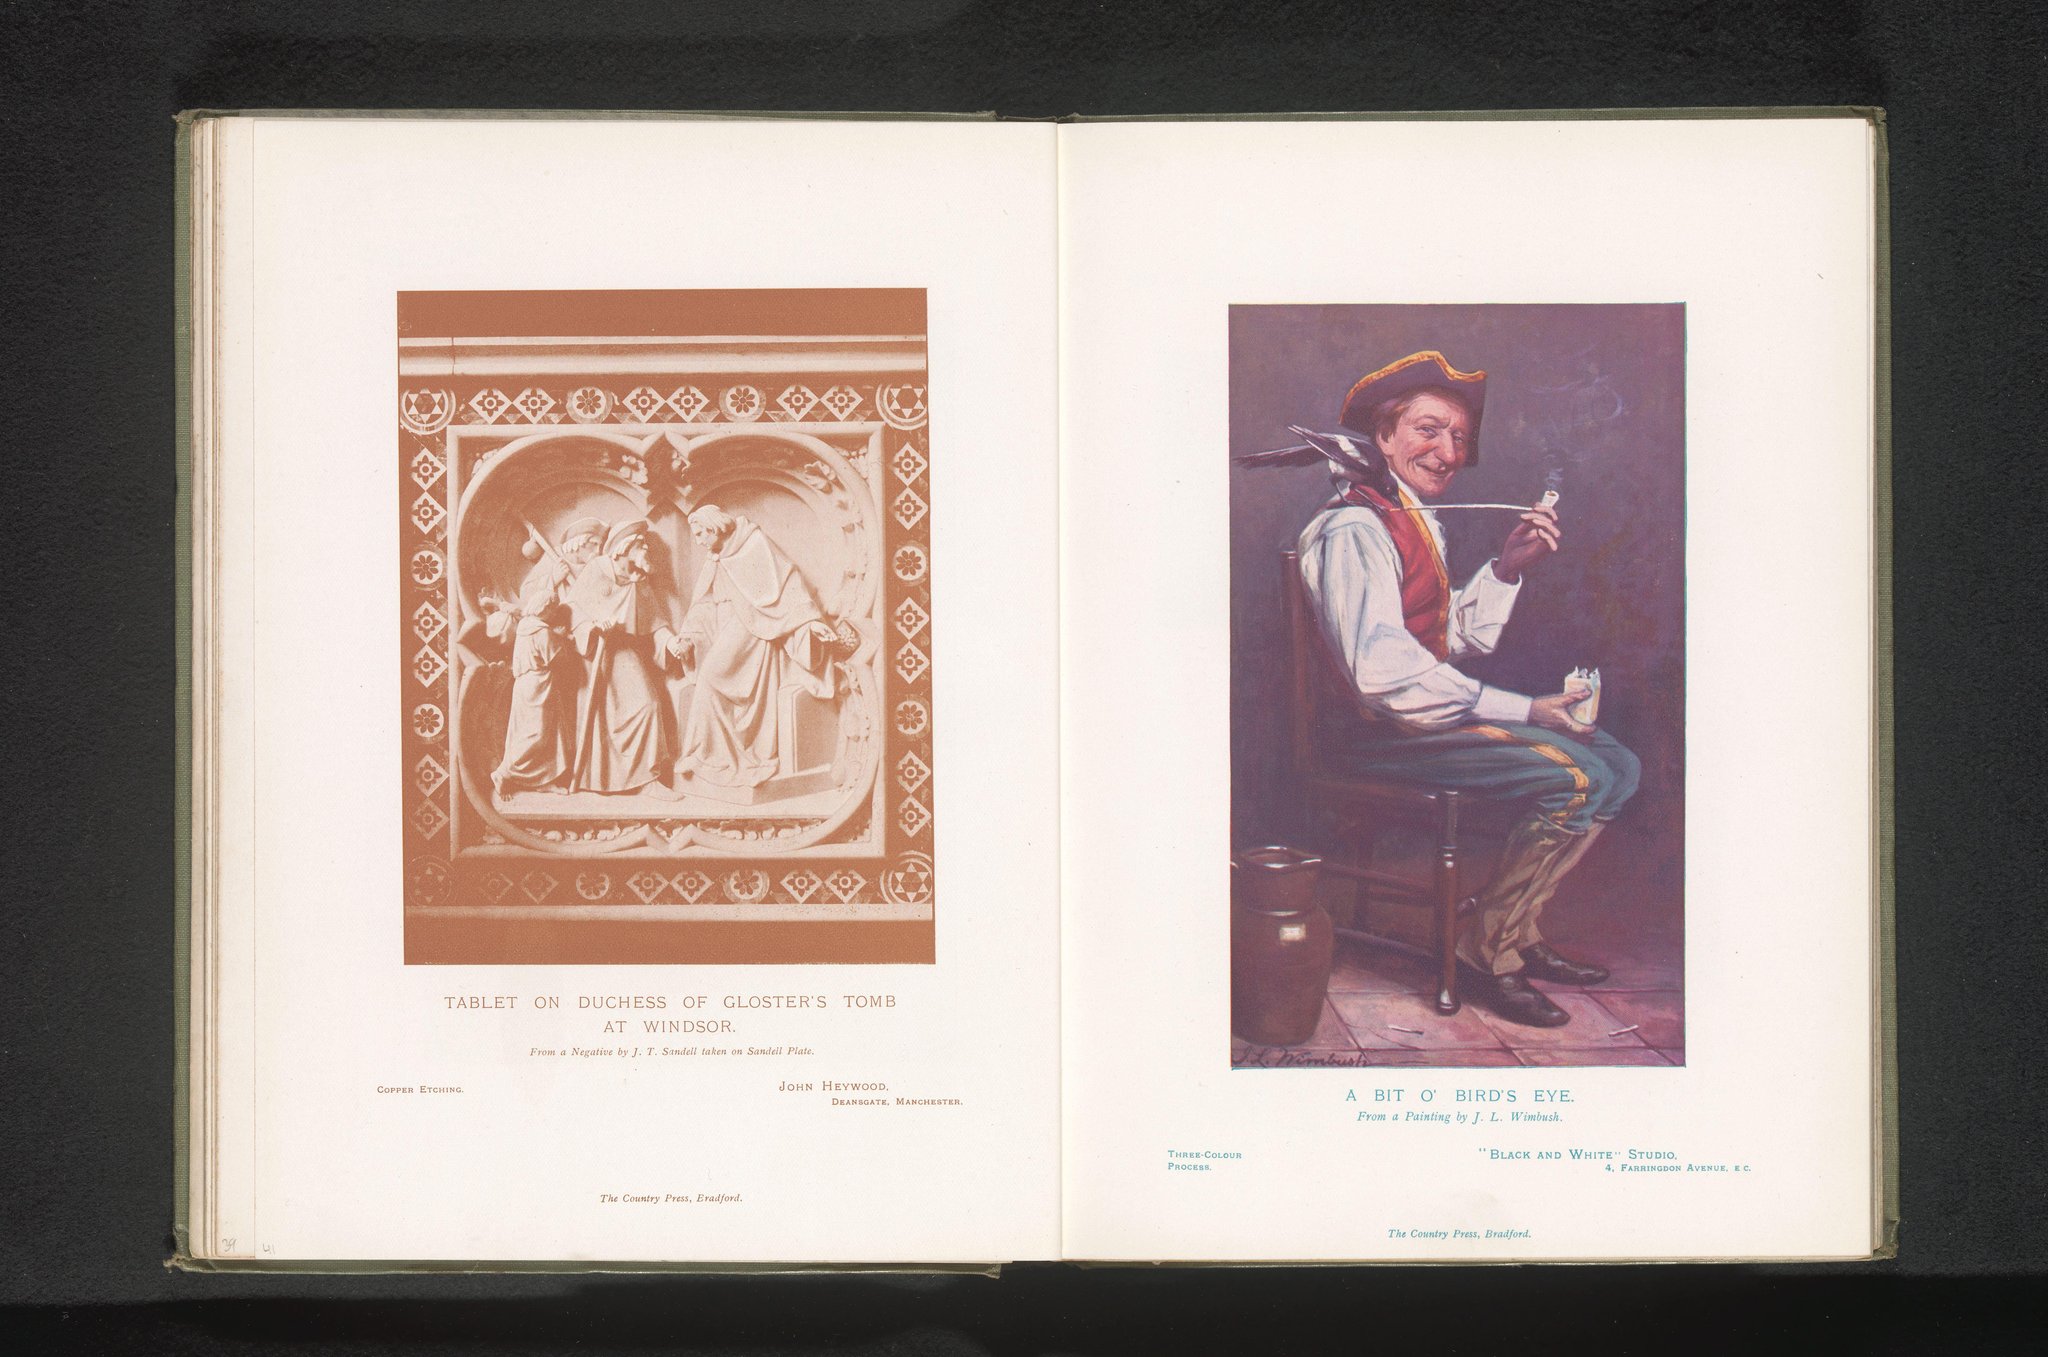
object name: photomechanical print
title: Reproductie van een schilderij van een portret van een onbekende man met een vogel en pijp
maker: john l. wimbush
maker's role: painter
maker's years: -1914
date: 1893-1898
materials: paper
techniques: three-color autotype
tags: historical persons, pipe ~ tobacco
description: Prent op vijfde ongenummerde pagina na pagina 48.